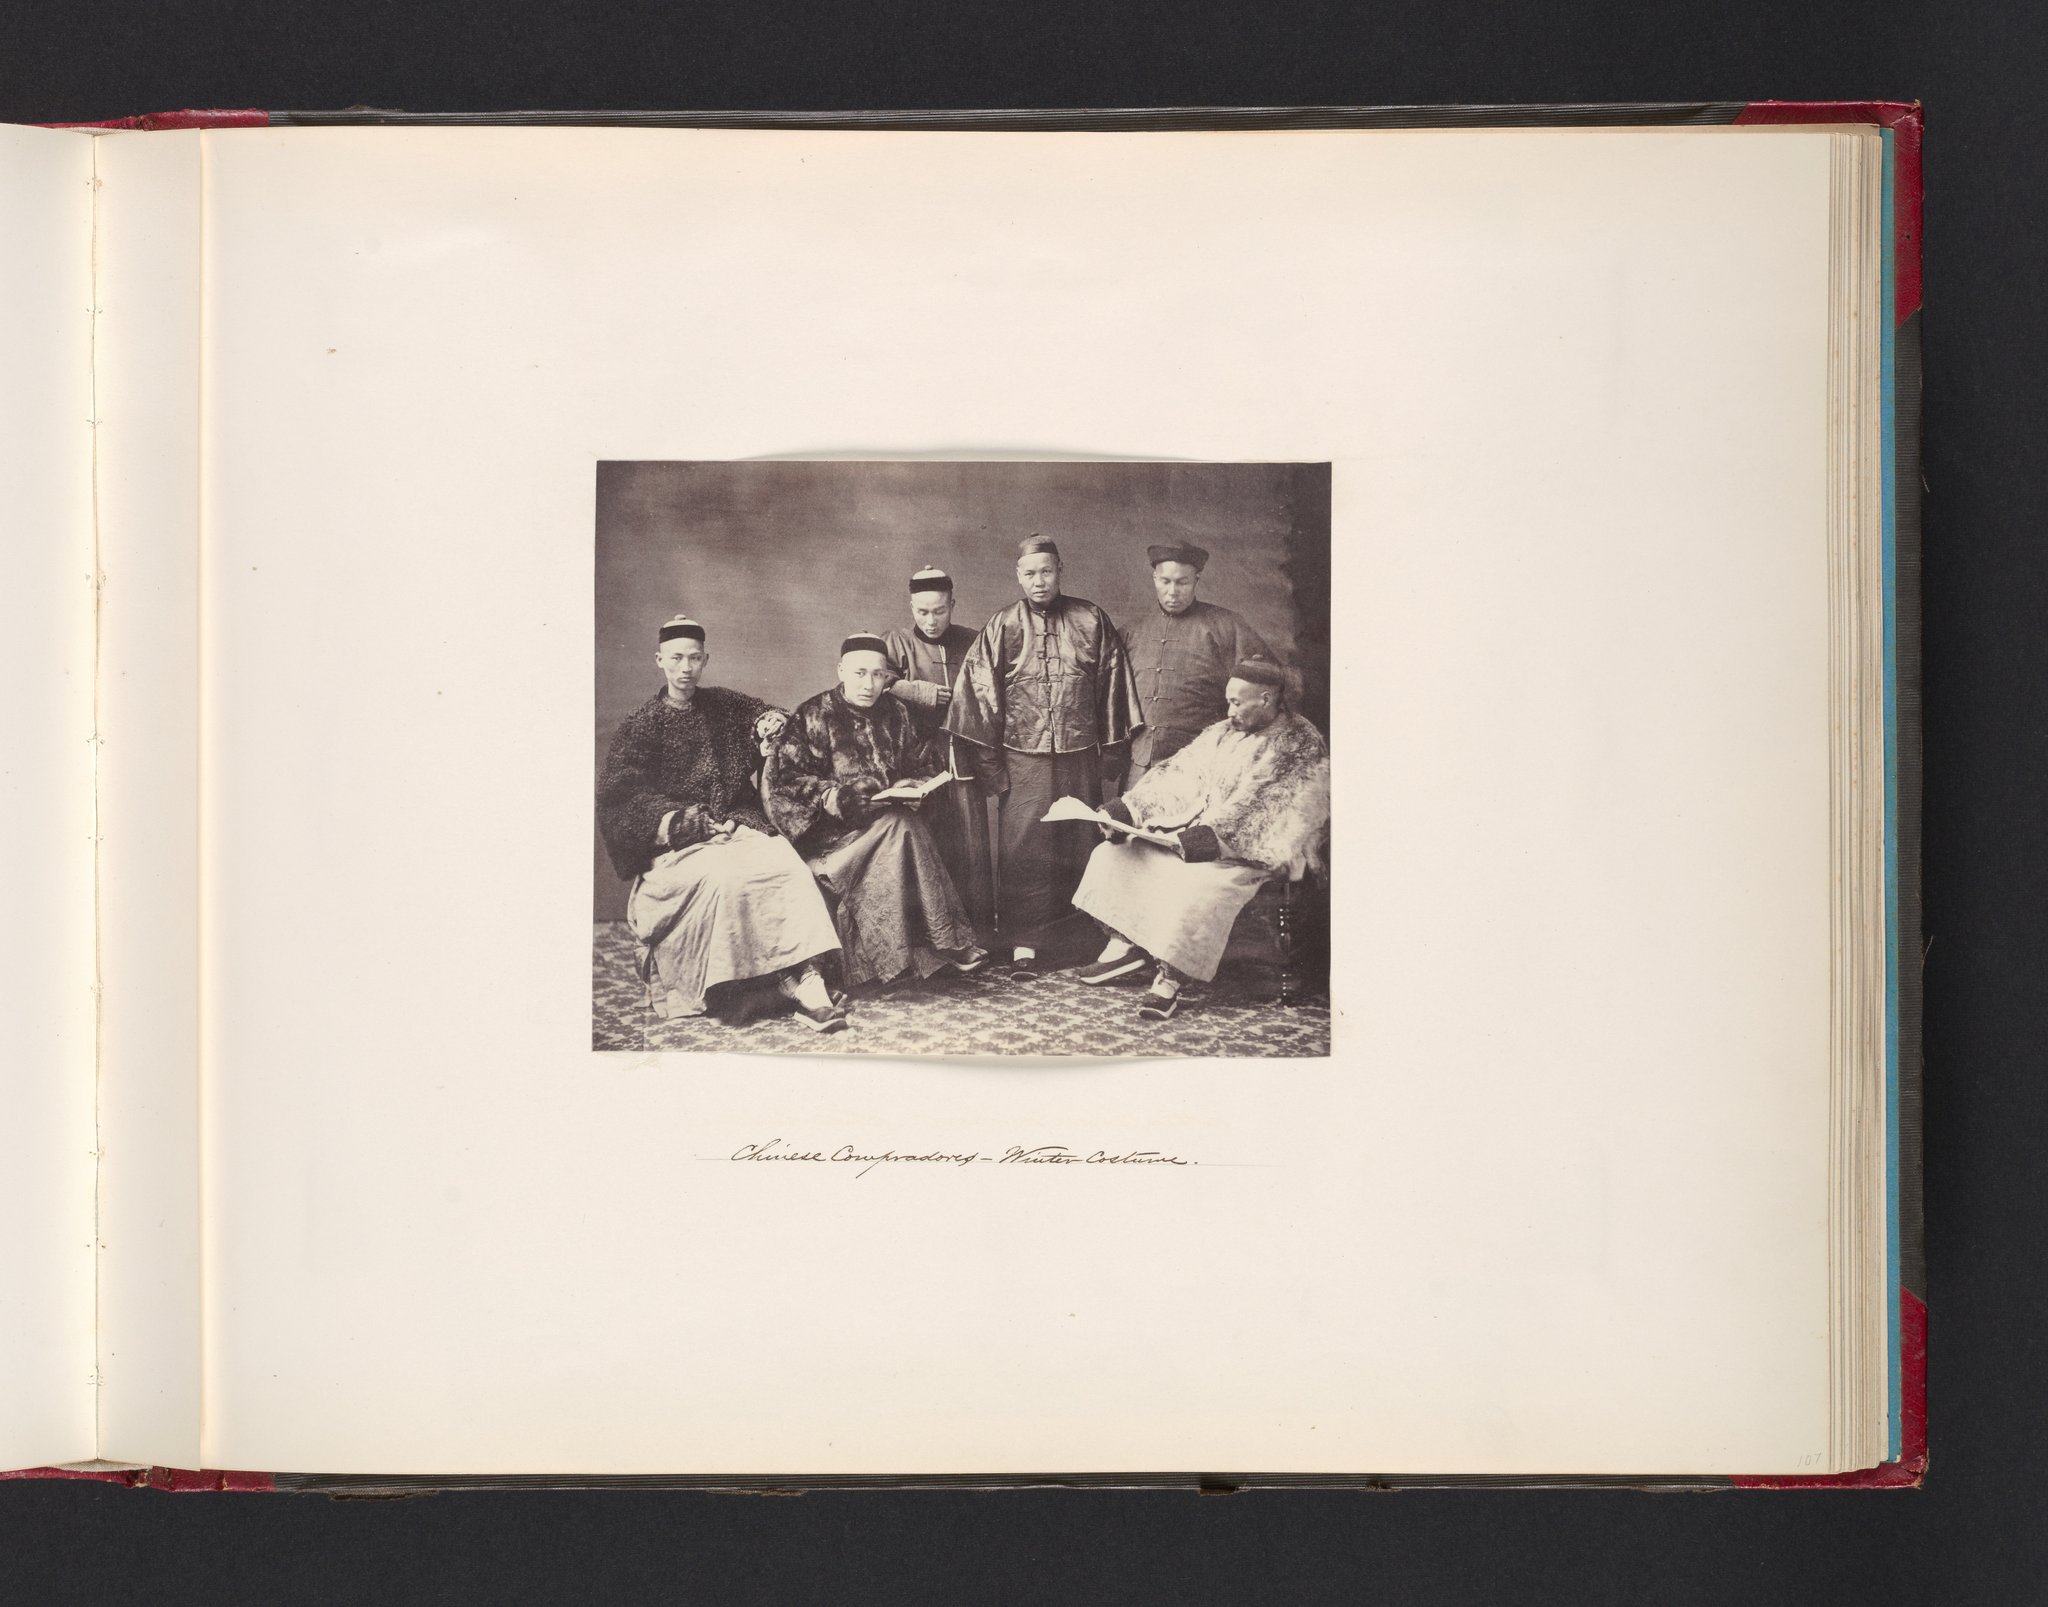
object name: photograph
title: Chinese Compradores, Winter Costume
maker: john thomson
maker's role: artist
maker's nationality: british, scottish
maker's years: 1837-1921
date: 1865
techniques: albumen silver print, glass negative